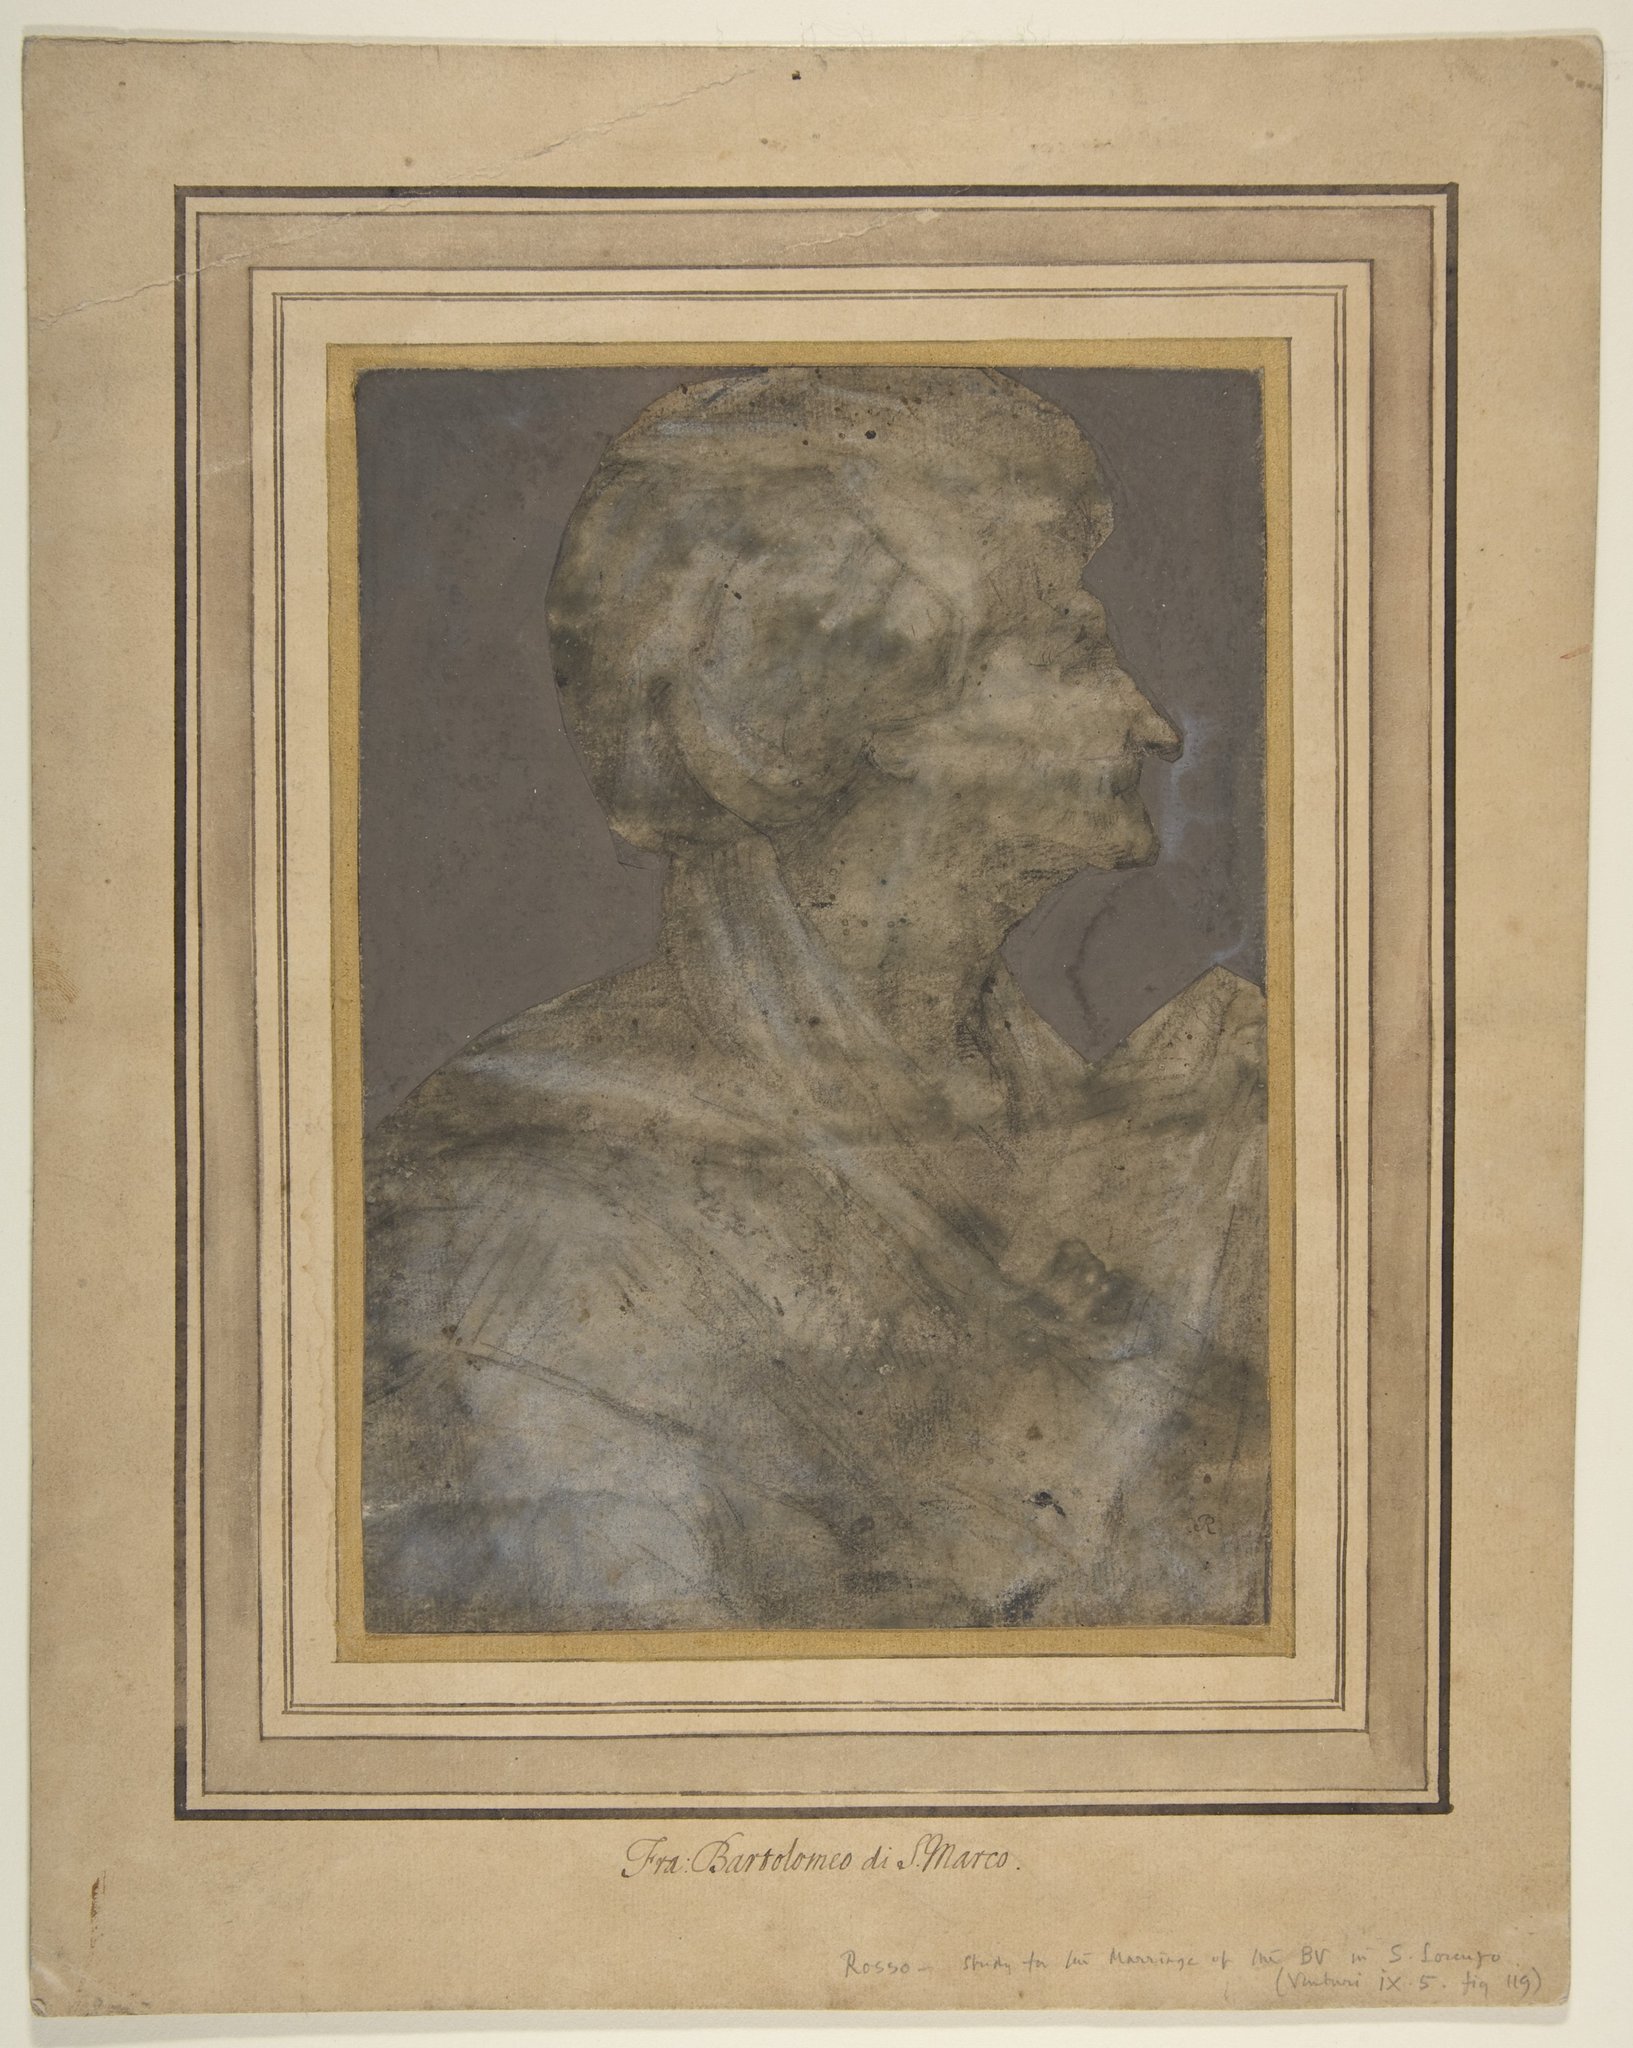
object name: drawing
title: Bust Of an Old Woman in Profile to Right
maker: rosso fiorentino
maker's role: artist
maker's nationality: italian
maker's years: 1494-1540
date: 1494-1540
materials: chalk, paper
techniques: highlighting, tinting, wash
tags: profiles,women